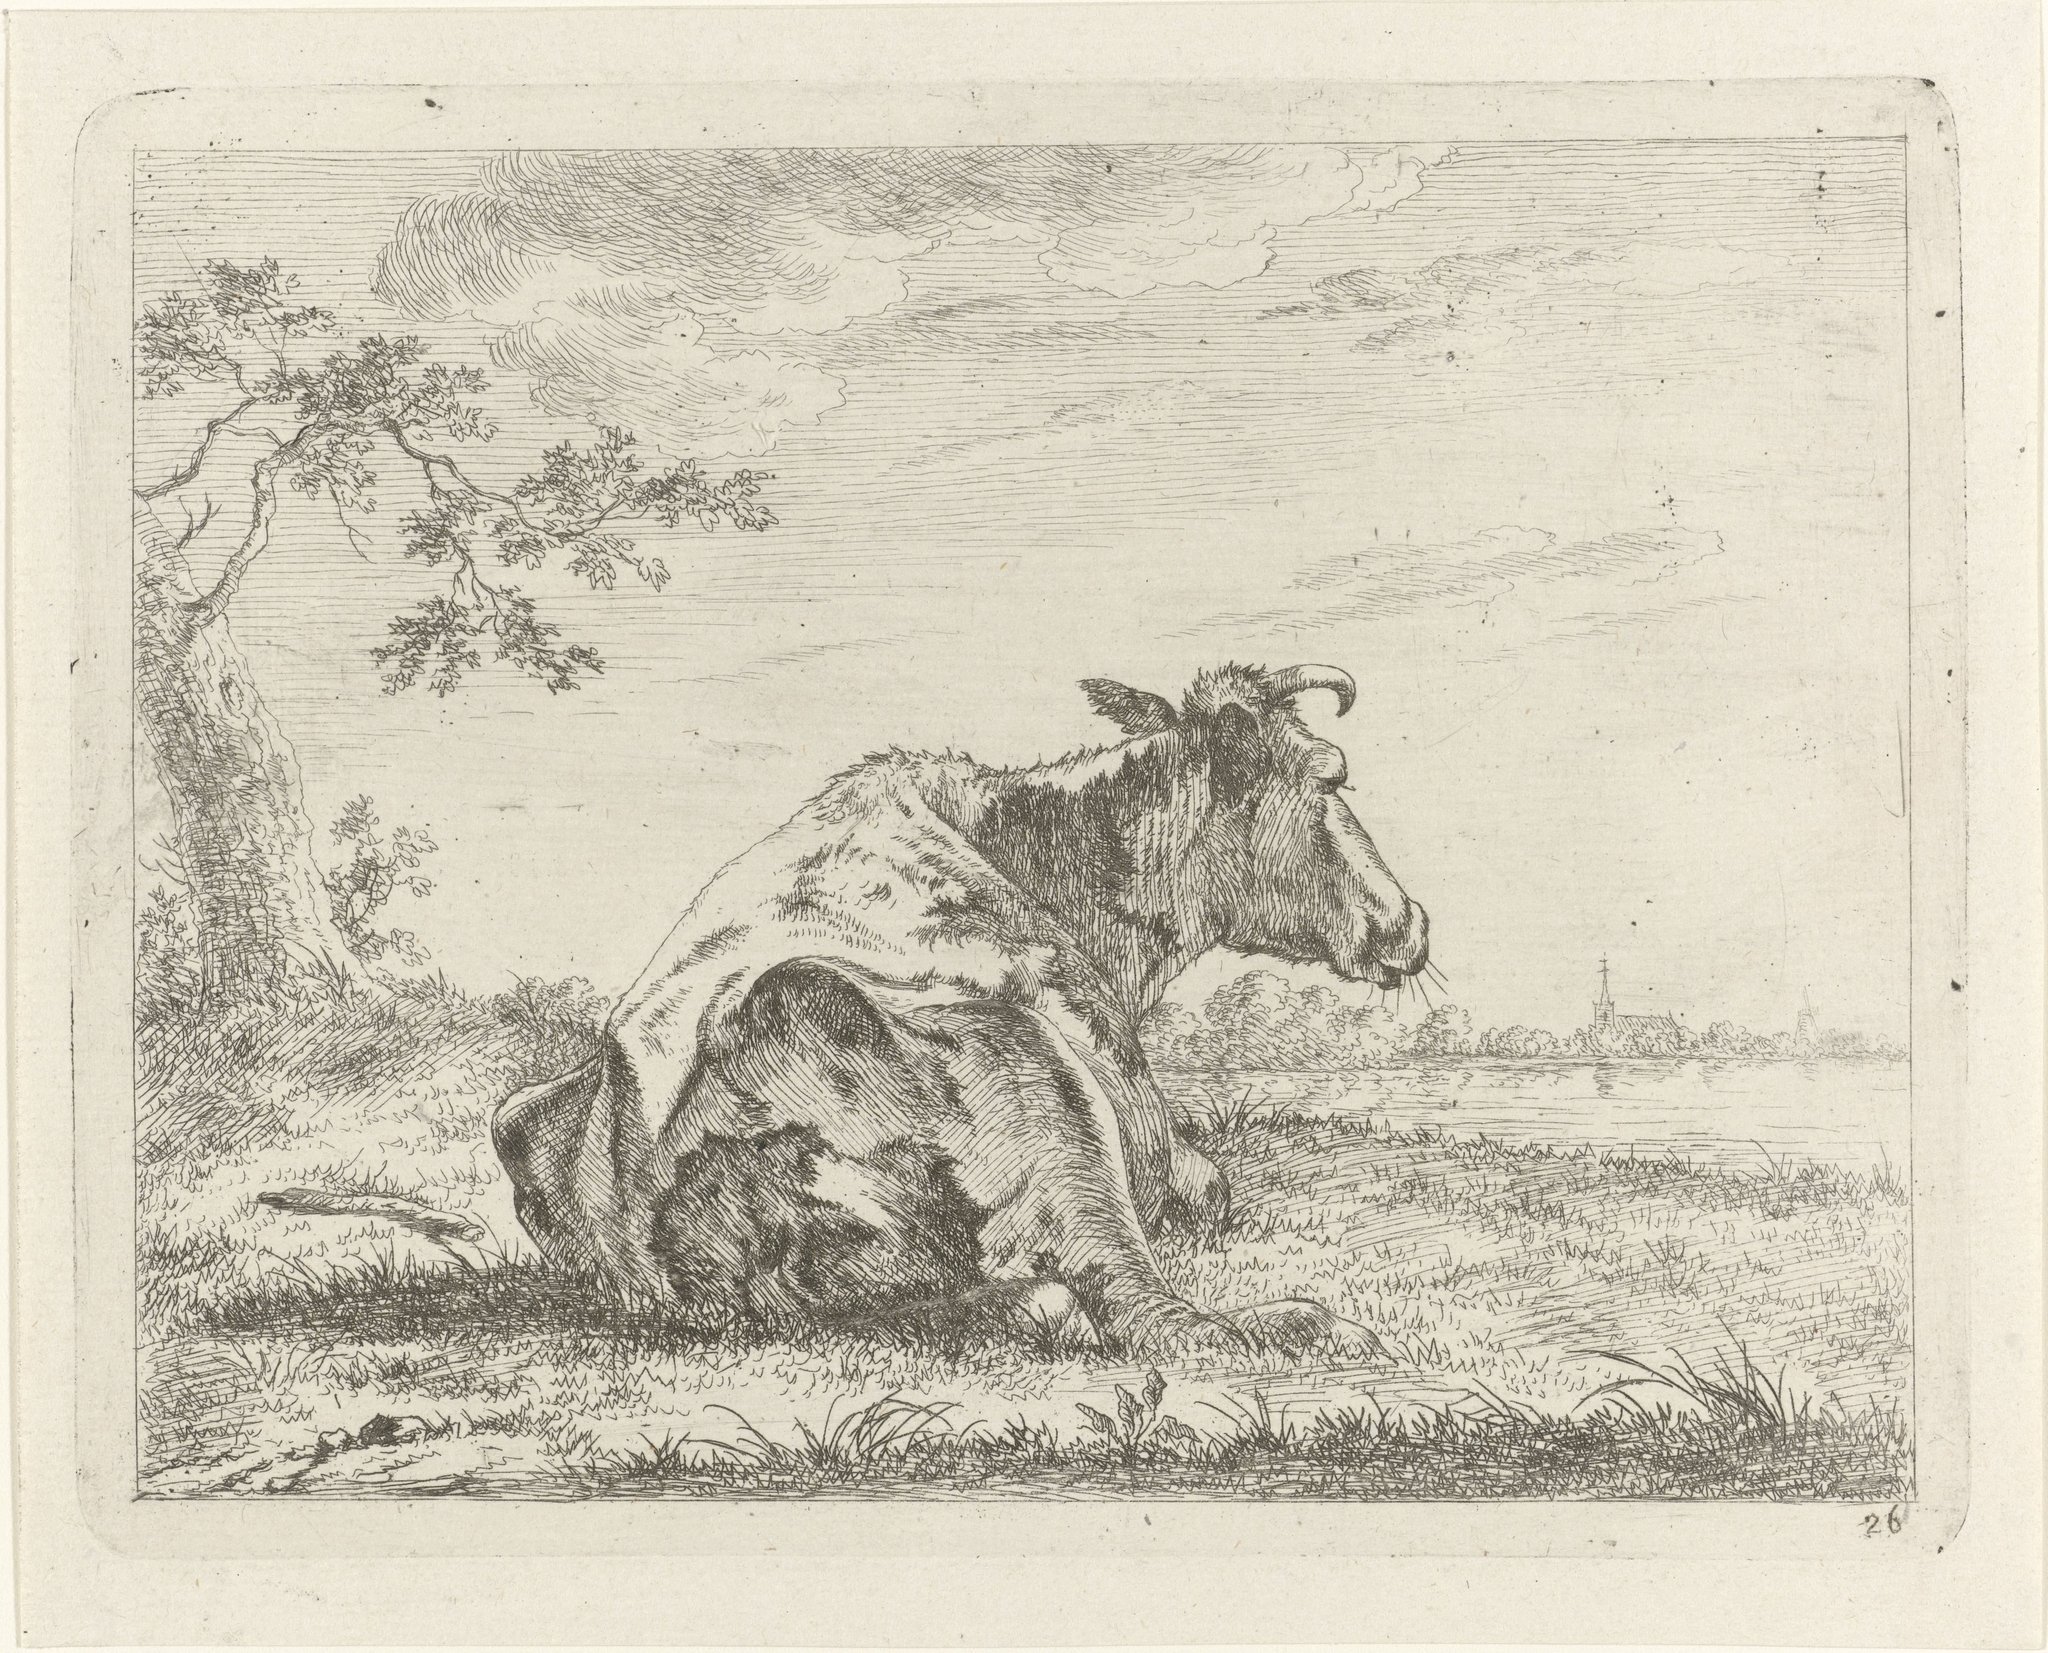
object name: print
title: Liggende koe aan waterkant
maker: johannes janson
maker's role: draughtsman, painter, print maker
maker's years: 1729-1784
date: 1761-1784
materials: paper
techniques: etching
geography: leiden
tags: cow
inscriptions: collector's mark: Lugt 2228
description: Liggende koe aan de waterkant, van achteren gezien. Links een boom. Rechtsonder: 26. Prent uit een serie met landschappen.